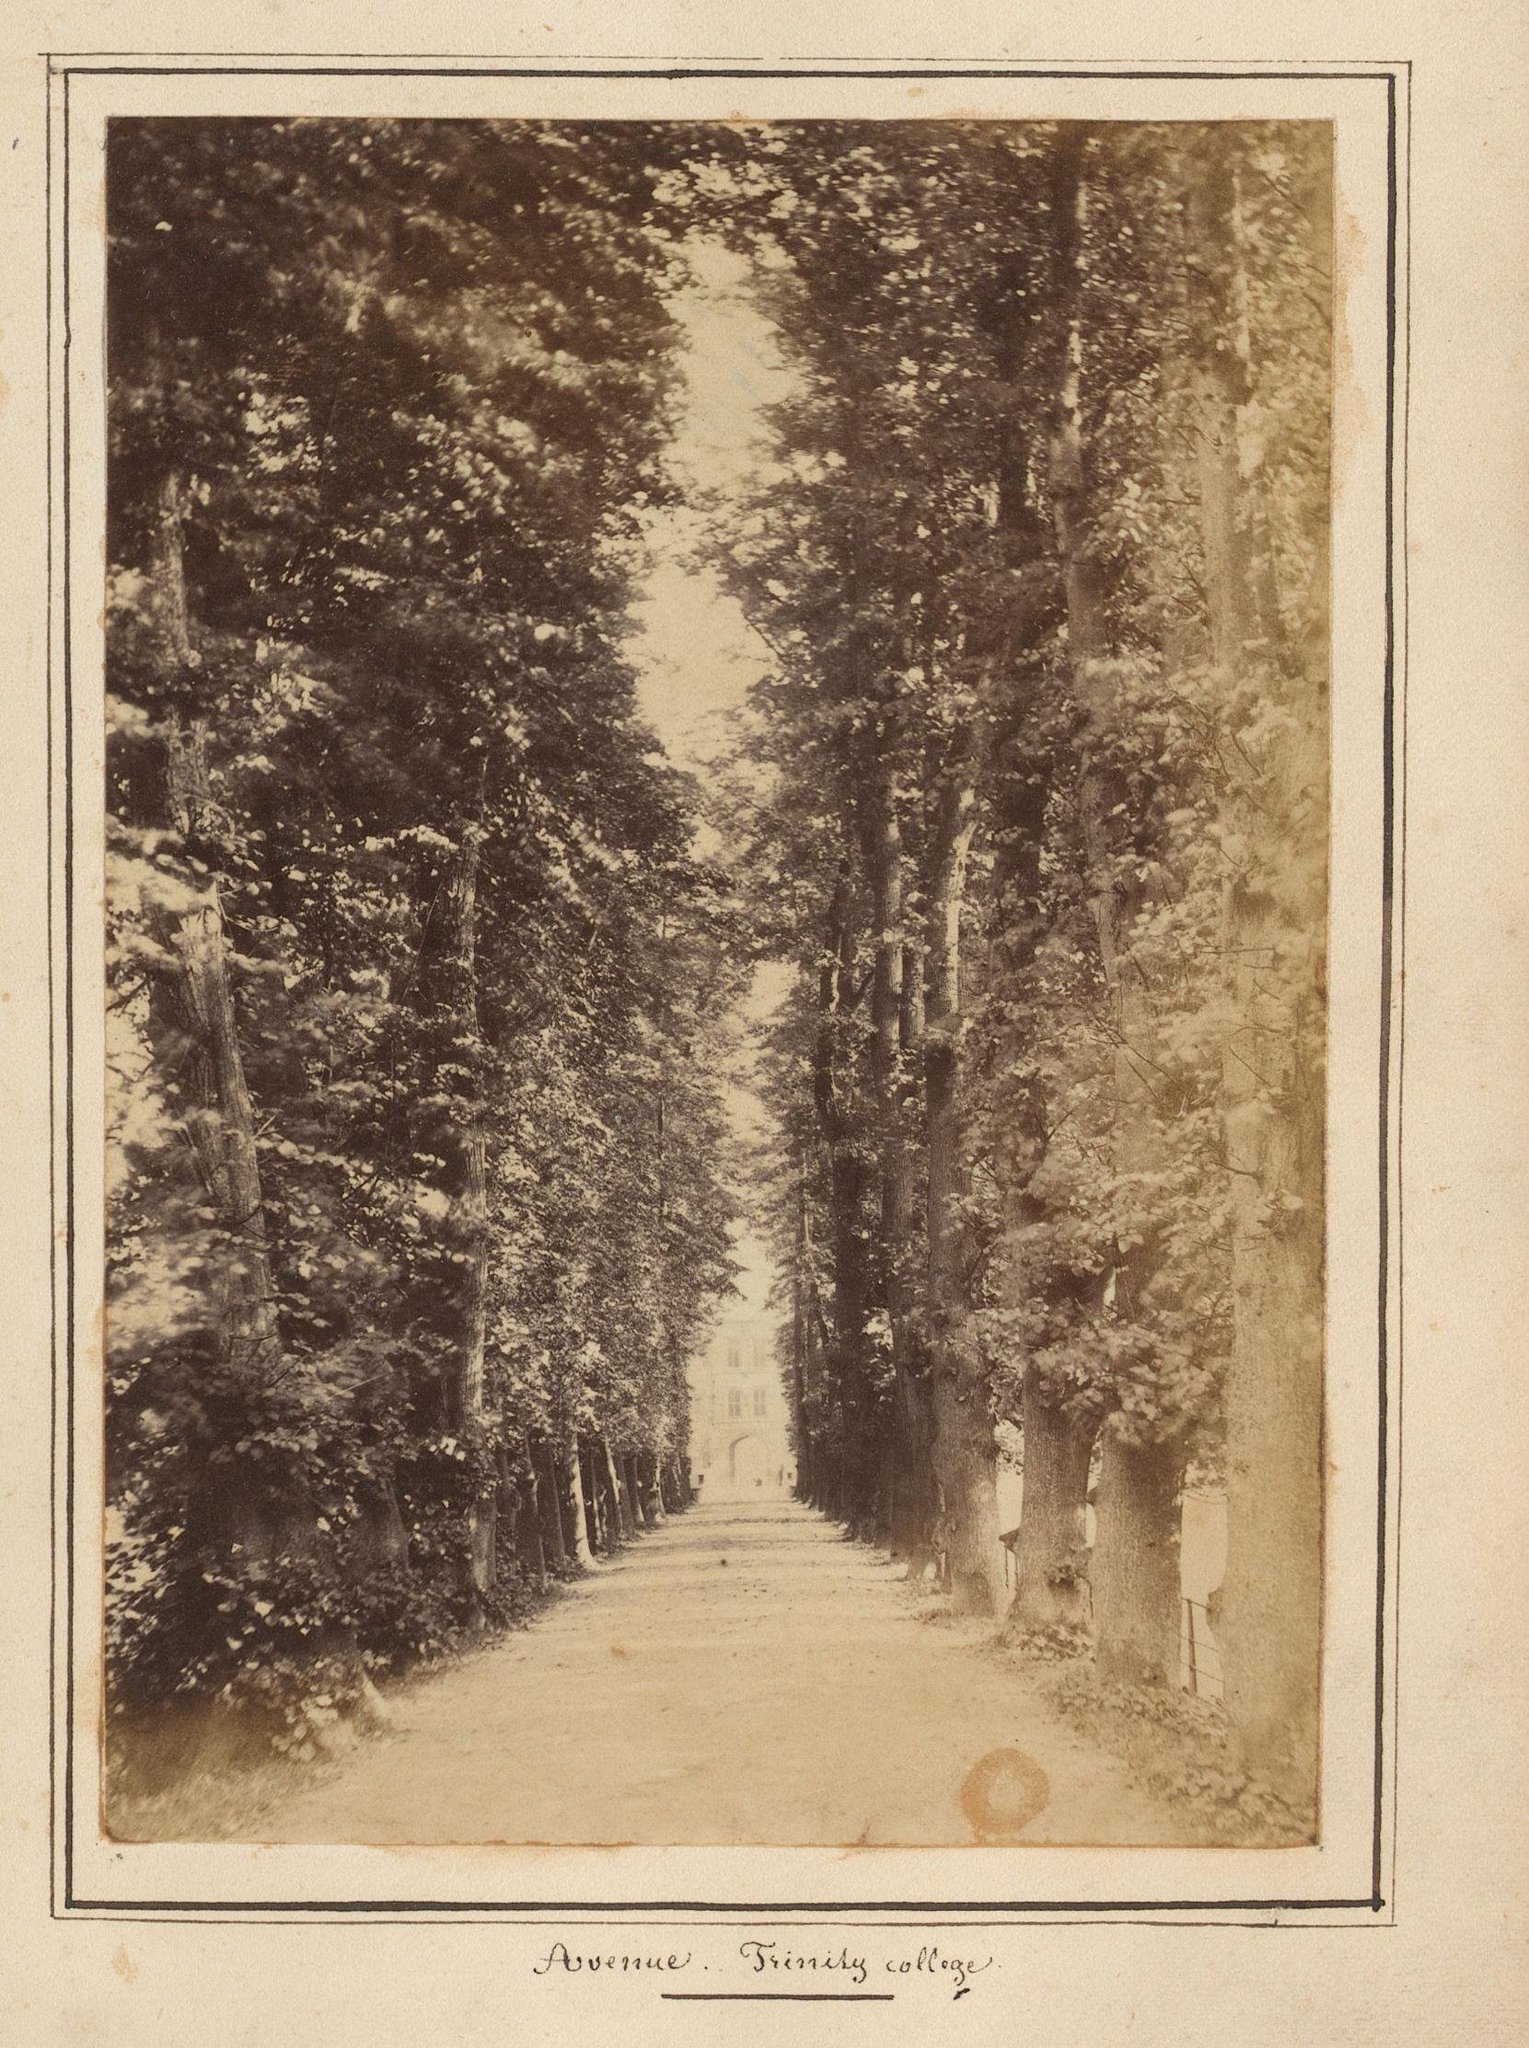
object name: photograph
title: Eetzaal van Trinity College, Cambridge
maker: Anonymous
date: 1865-1890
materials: paper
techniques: albumen print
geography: cambridge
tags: university building, college, dining-room